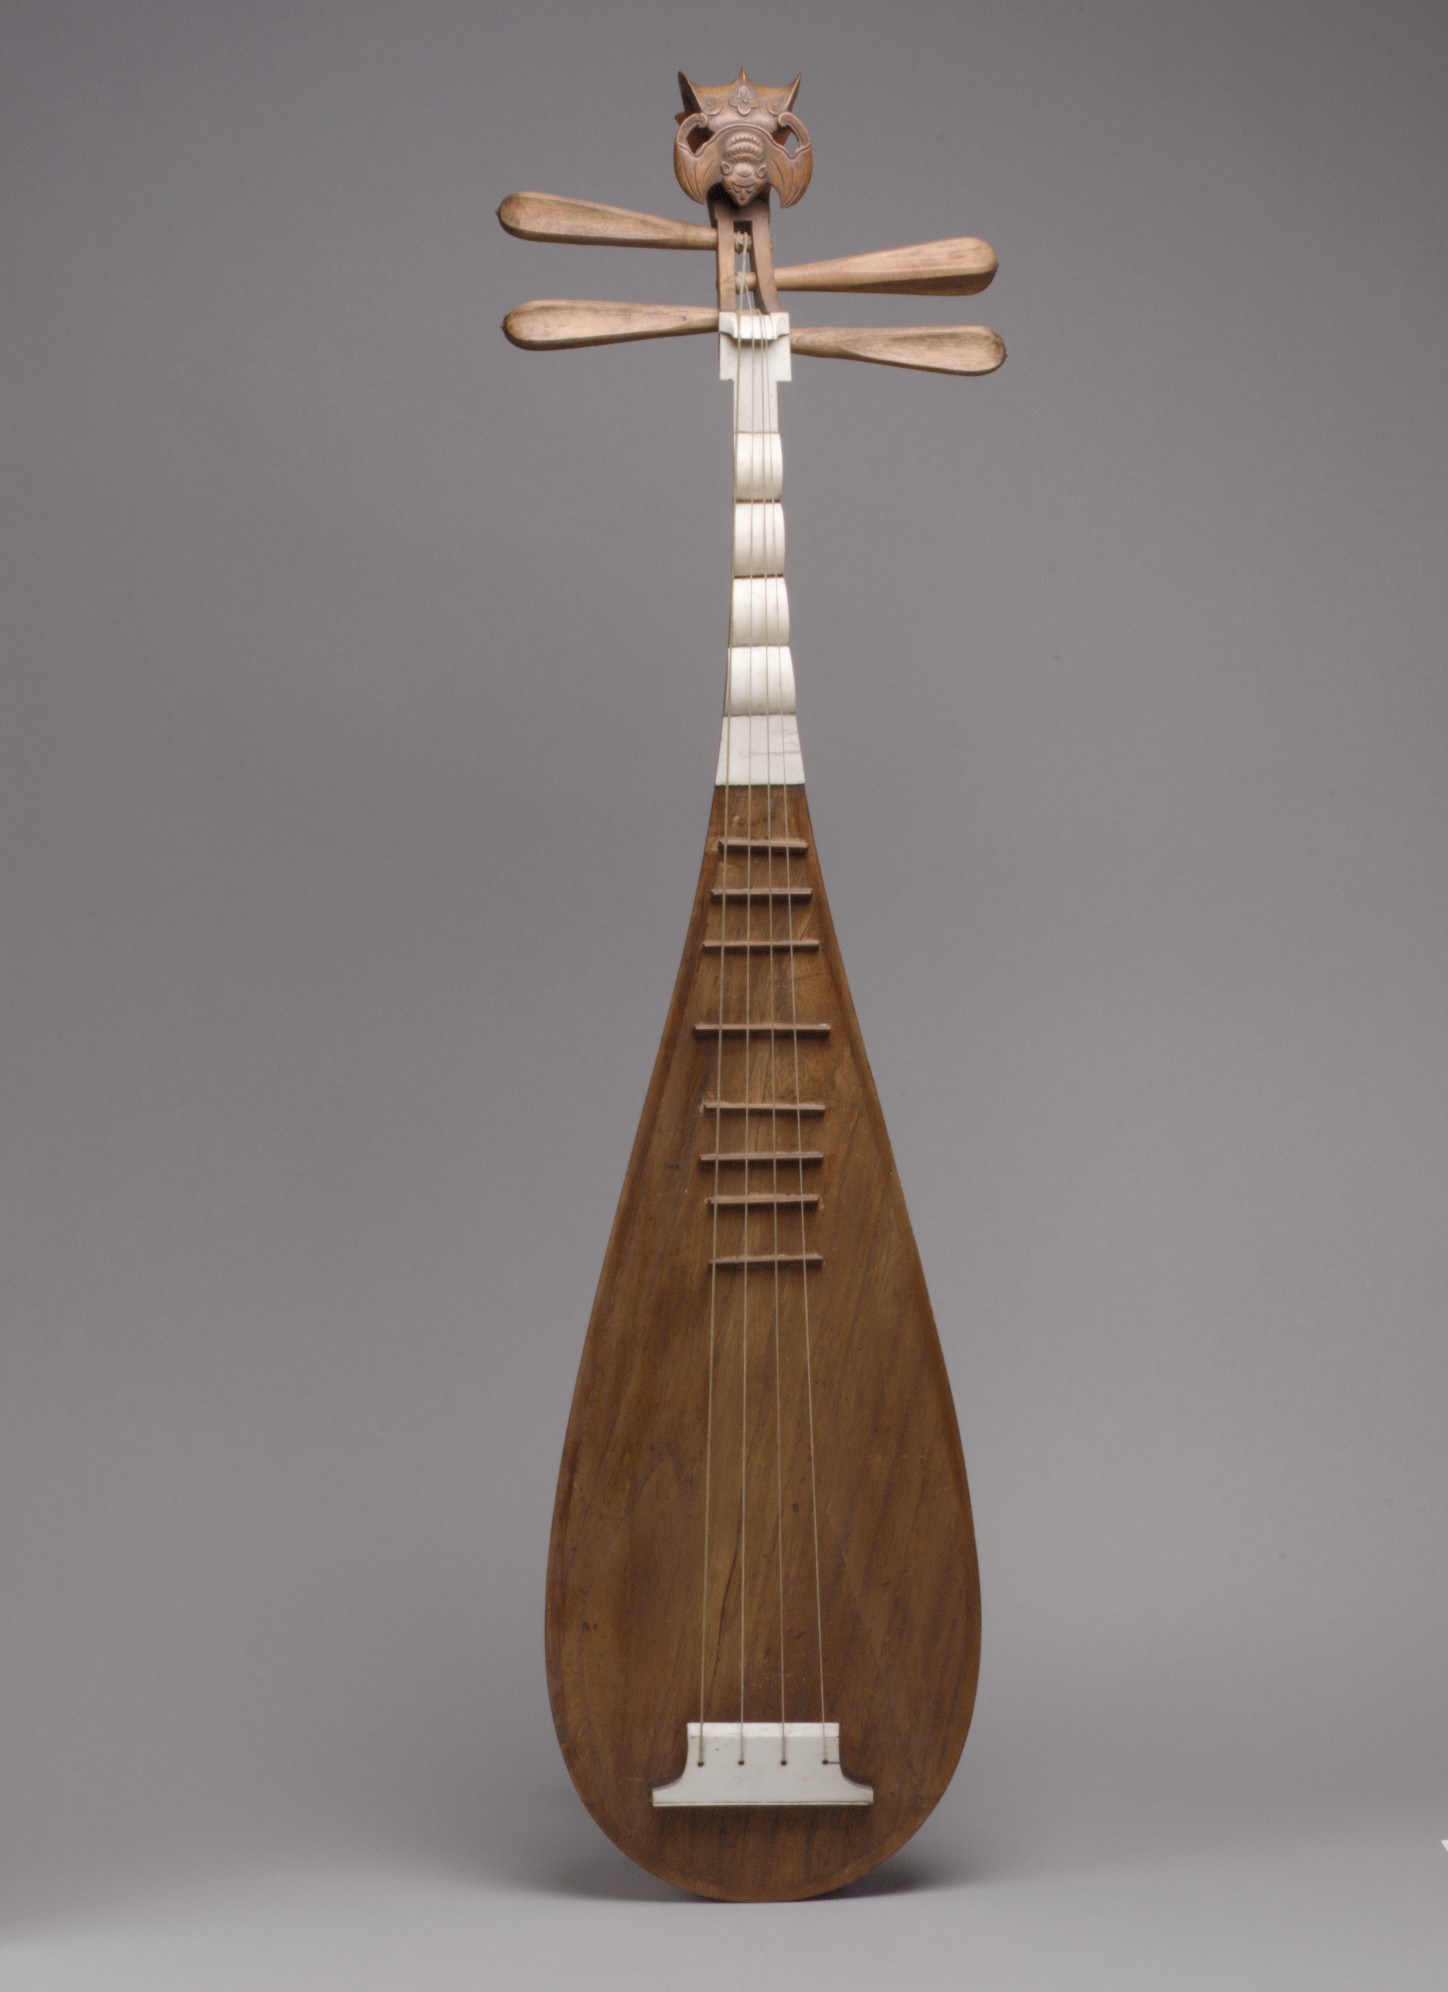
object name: pipa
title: Pipa (琵琶 )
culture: chinese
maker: jiu-cheng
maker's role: maker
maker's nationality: chinese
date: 1801-1900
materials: bone, ivory, wood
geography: china